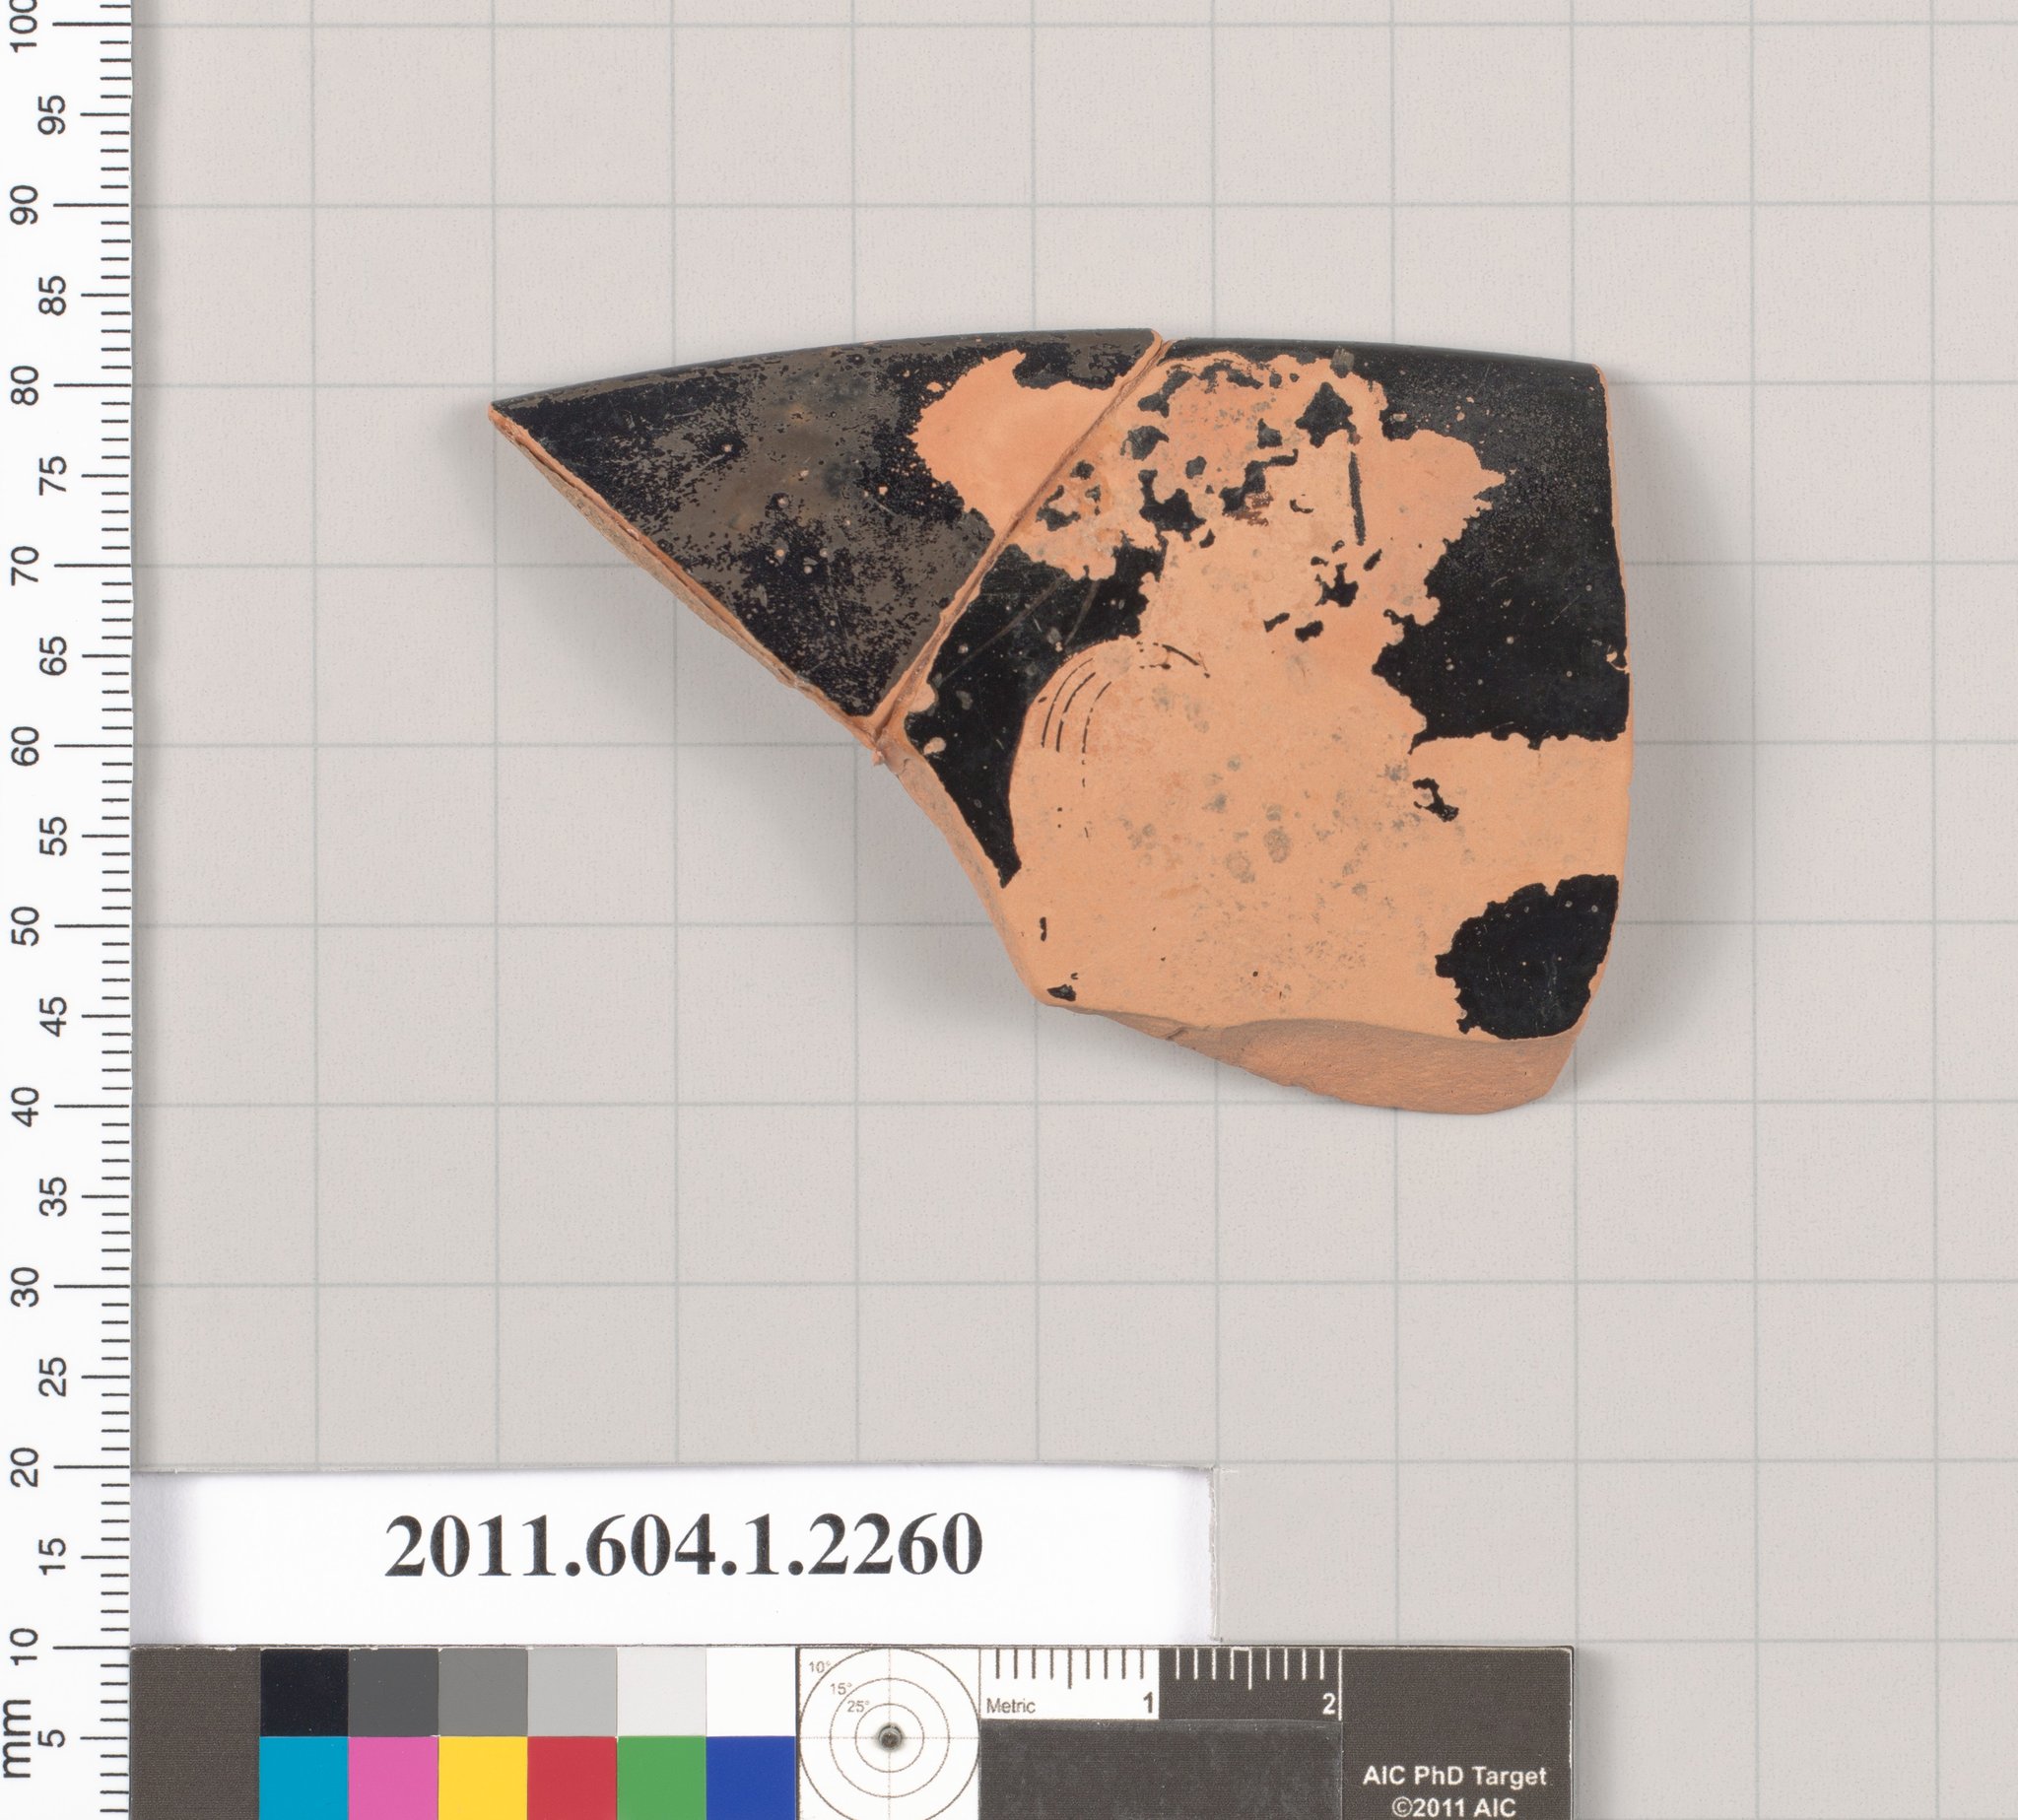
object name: kylix fragment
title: Terracotta rim fragment of a kylix (drinking cup)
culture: greek, attic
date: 467-435 BCE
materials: terracotta